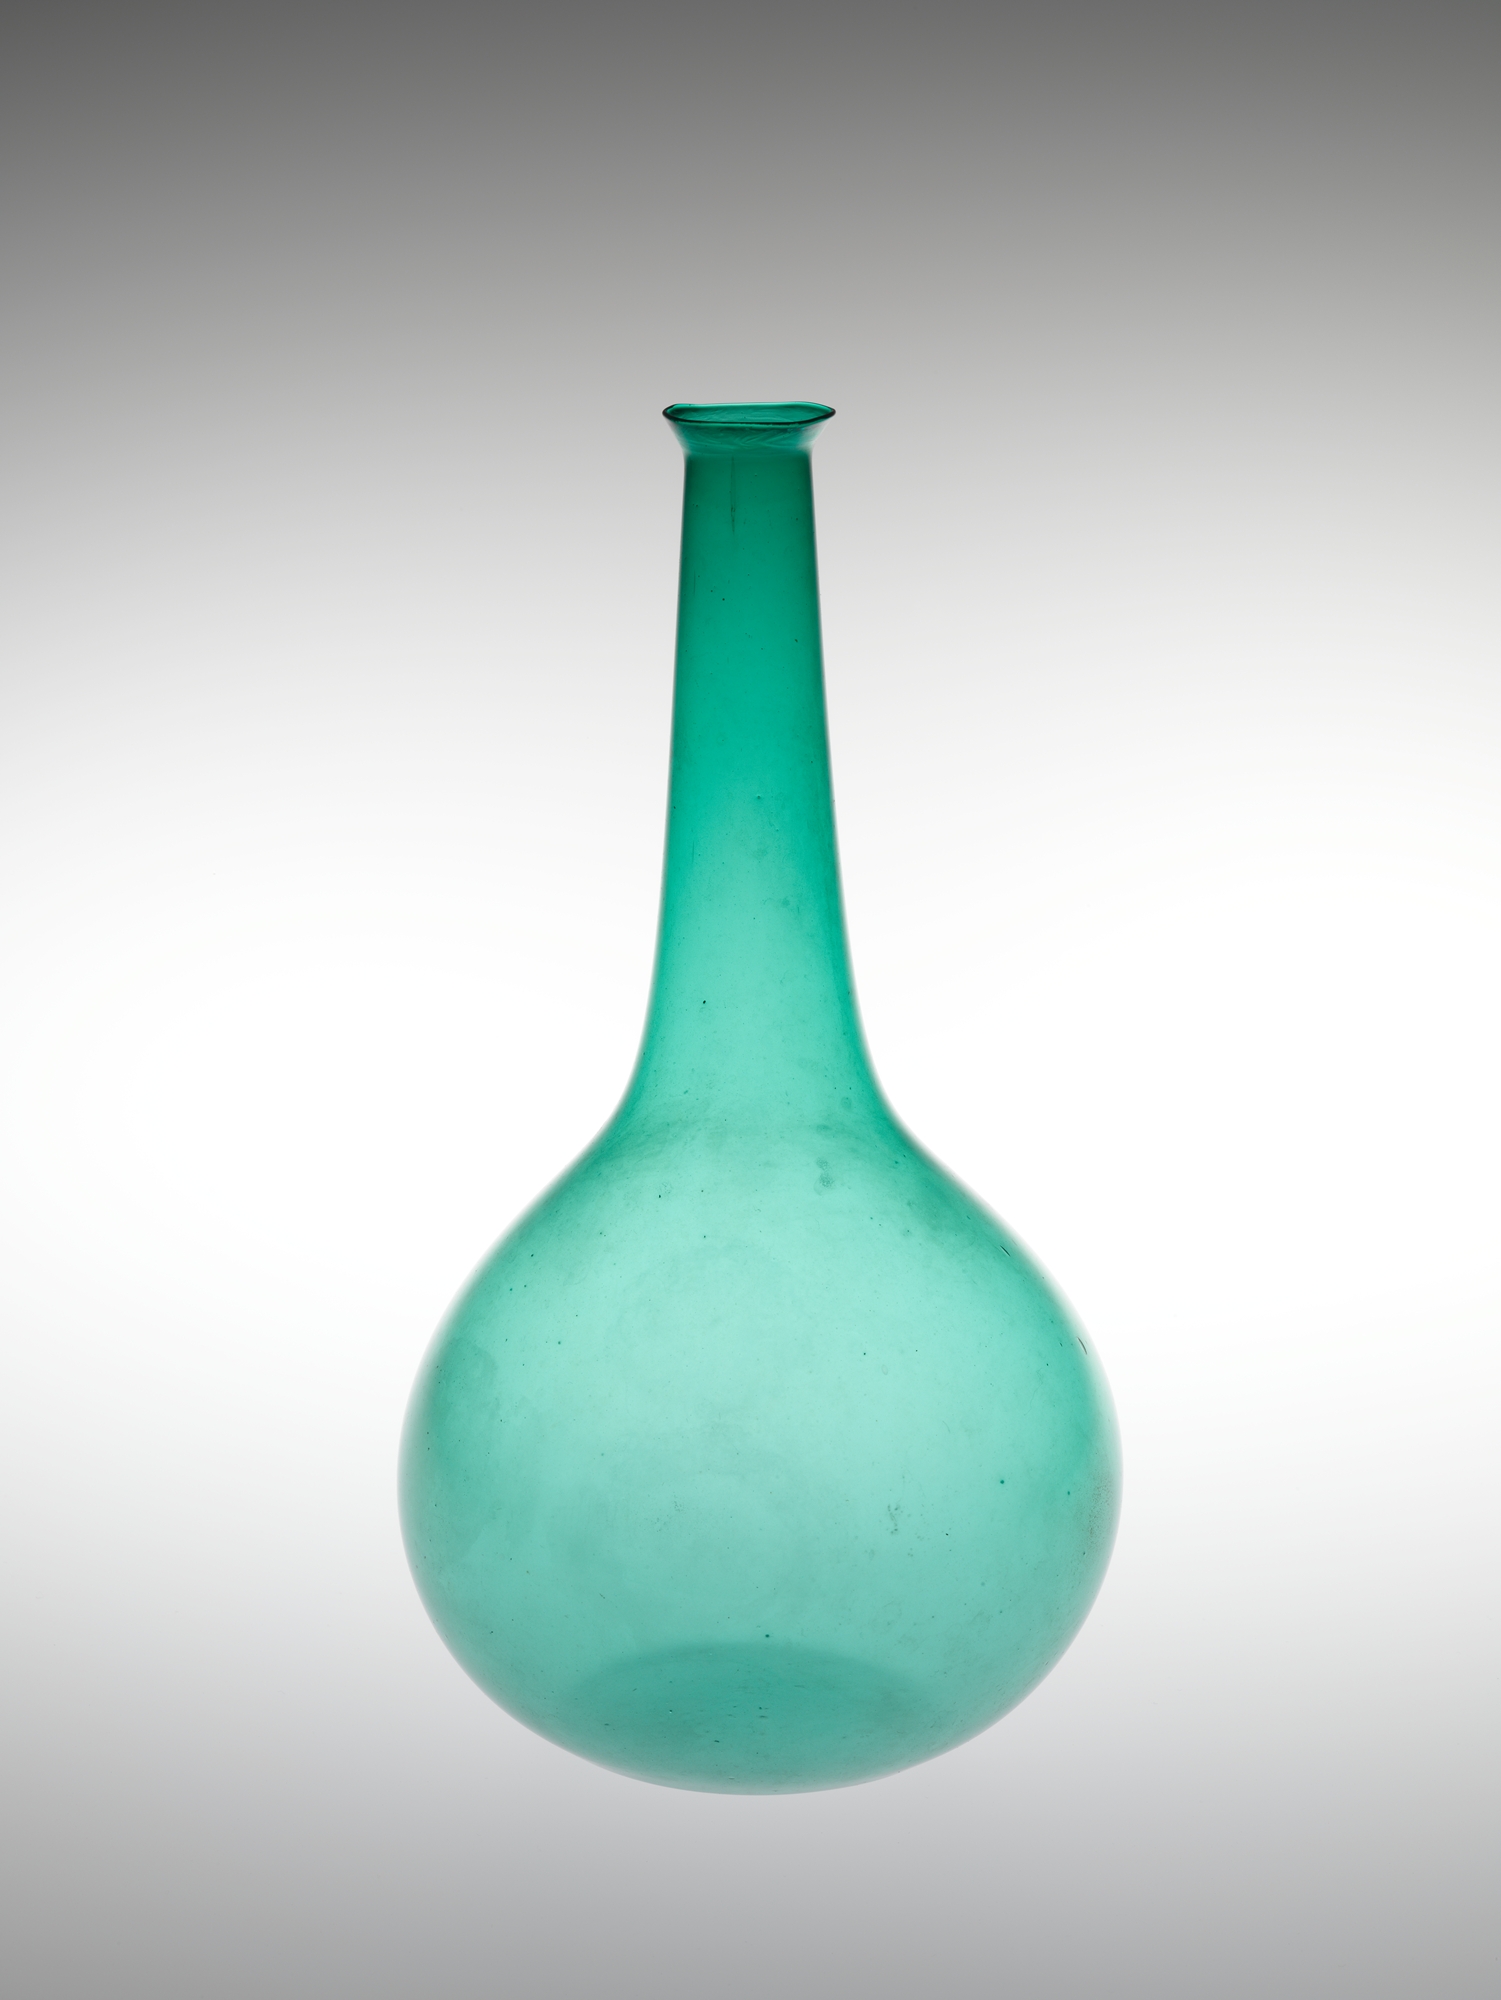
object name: flask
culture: japanese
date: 1801-1900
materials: glass